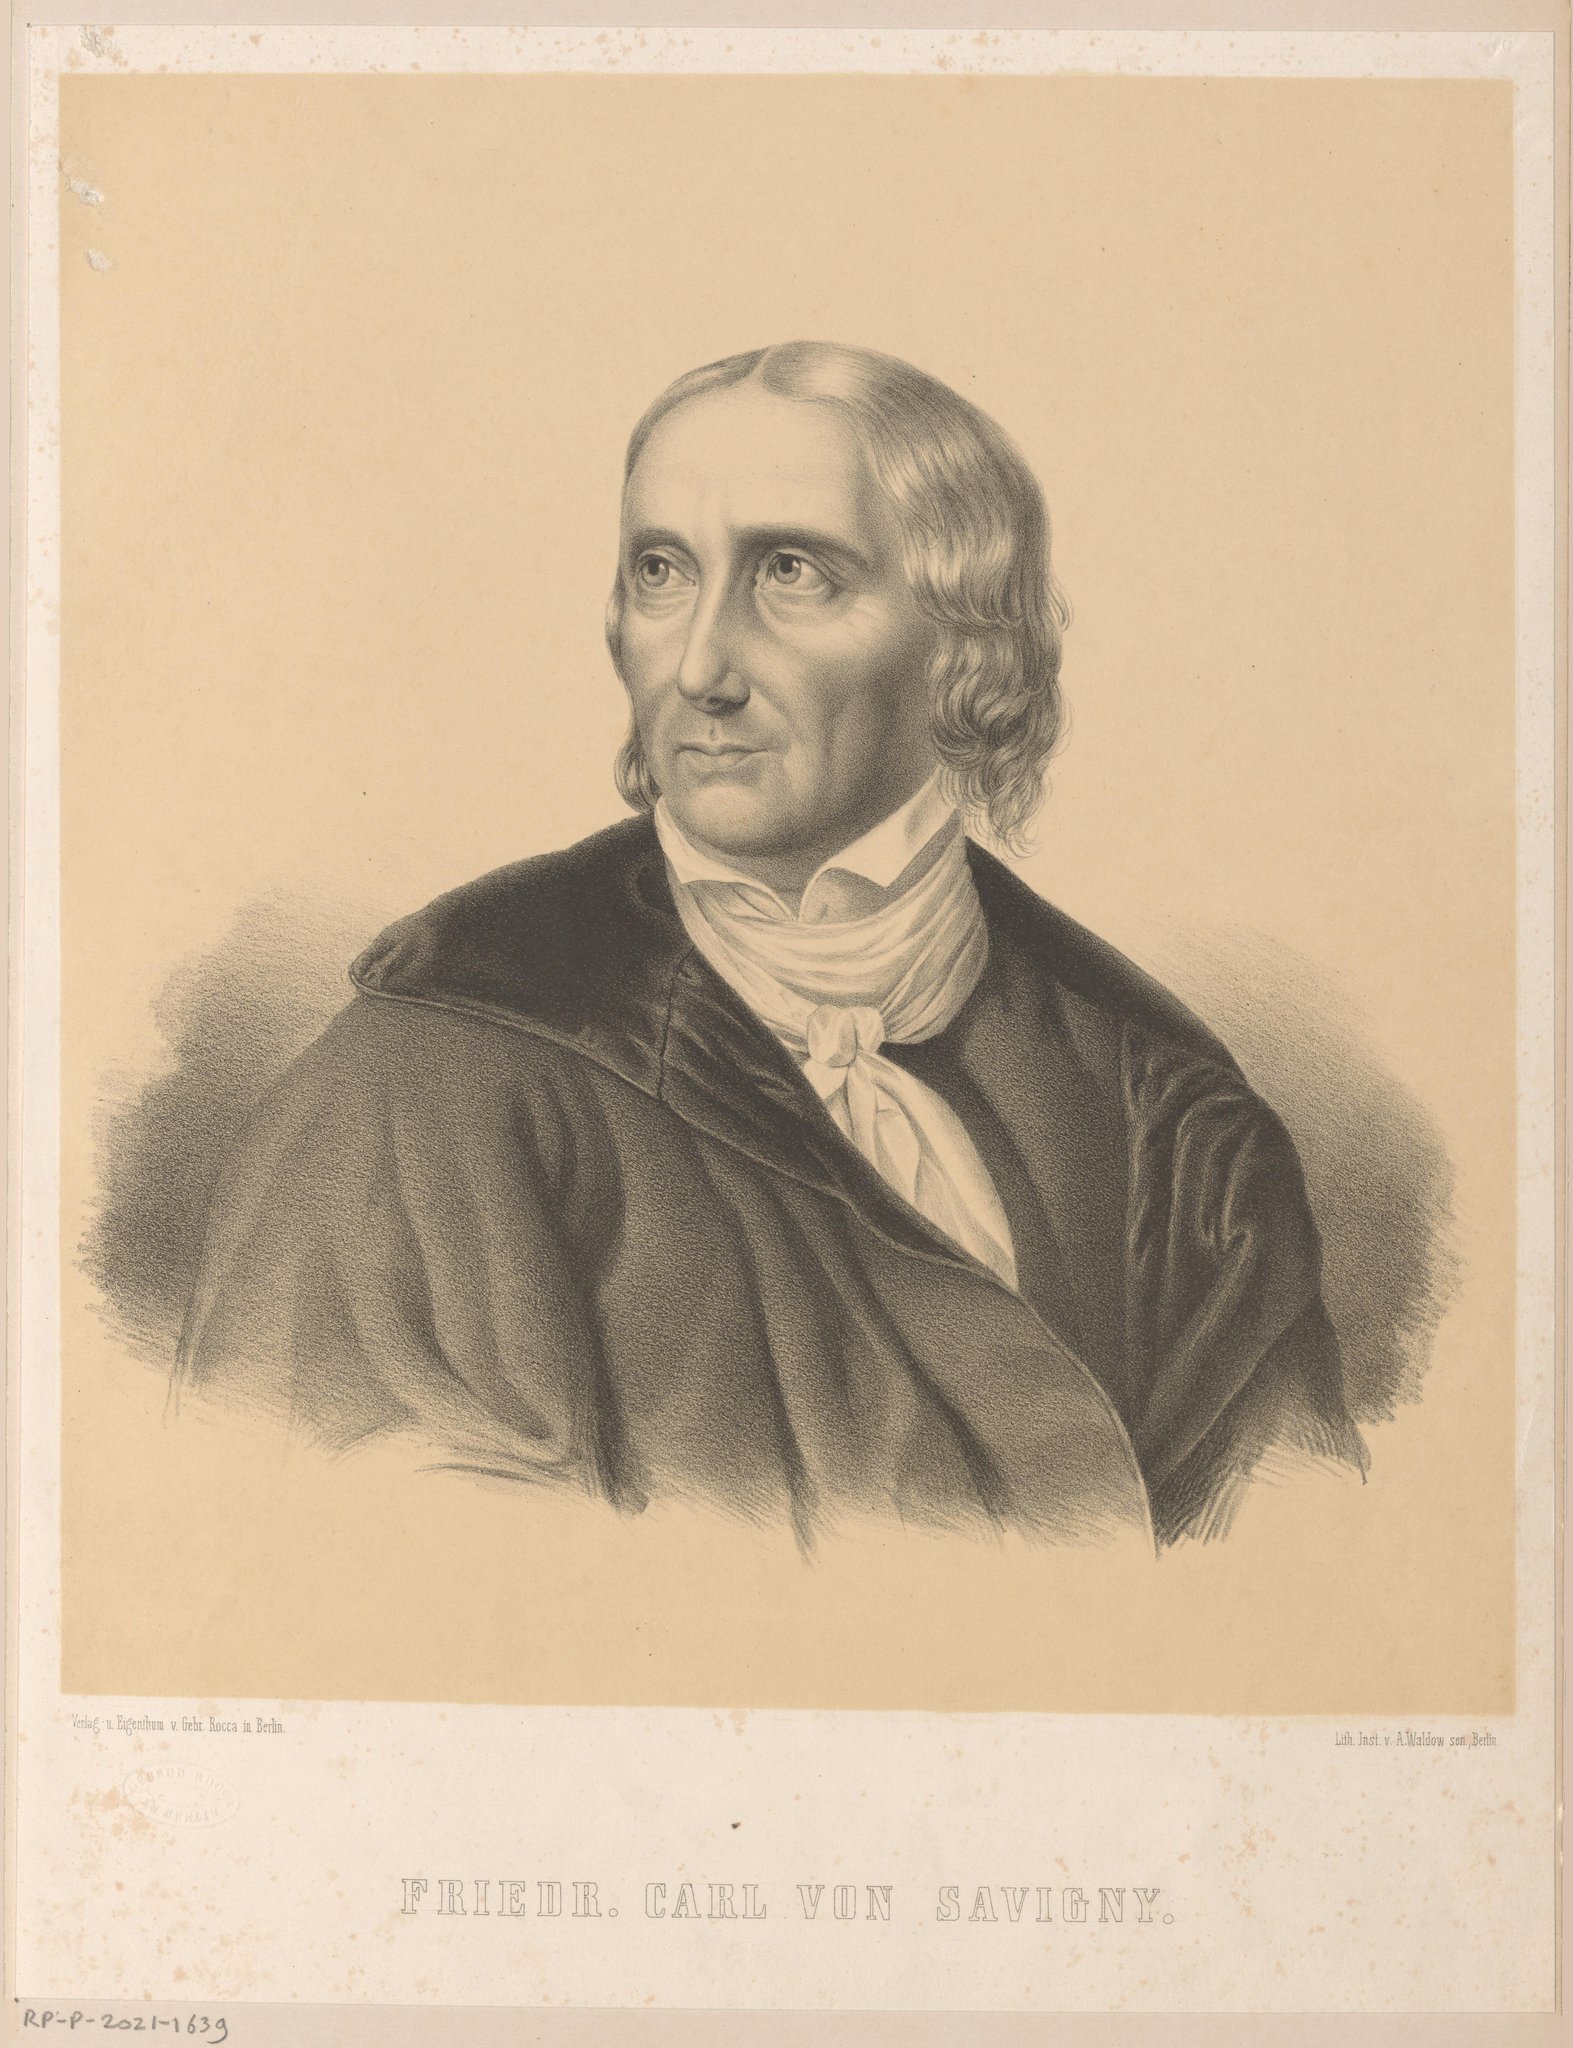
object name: print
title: Portret van Friedrich Carl von Savigny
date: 1830-1863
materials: paper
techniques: tone lithography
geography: berlin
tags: berlin, historical persons, law and jurisprudence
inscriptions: check stamp: Lugt 2141c, collector's mark: Lugt 2228